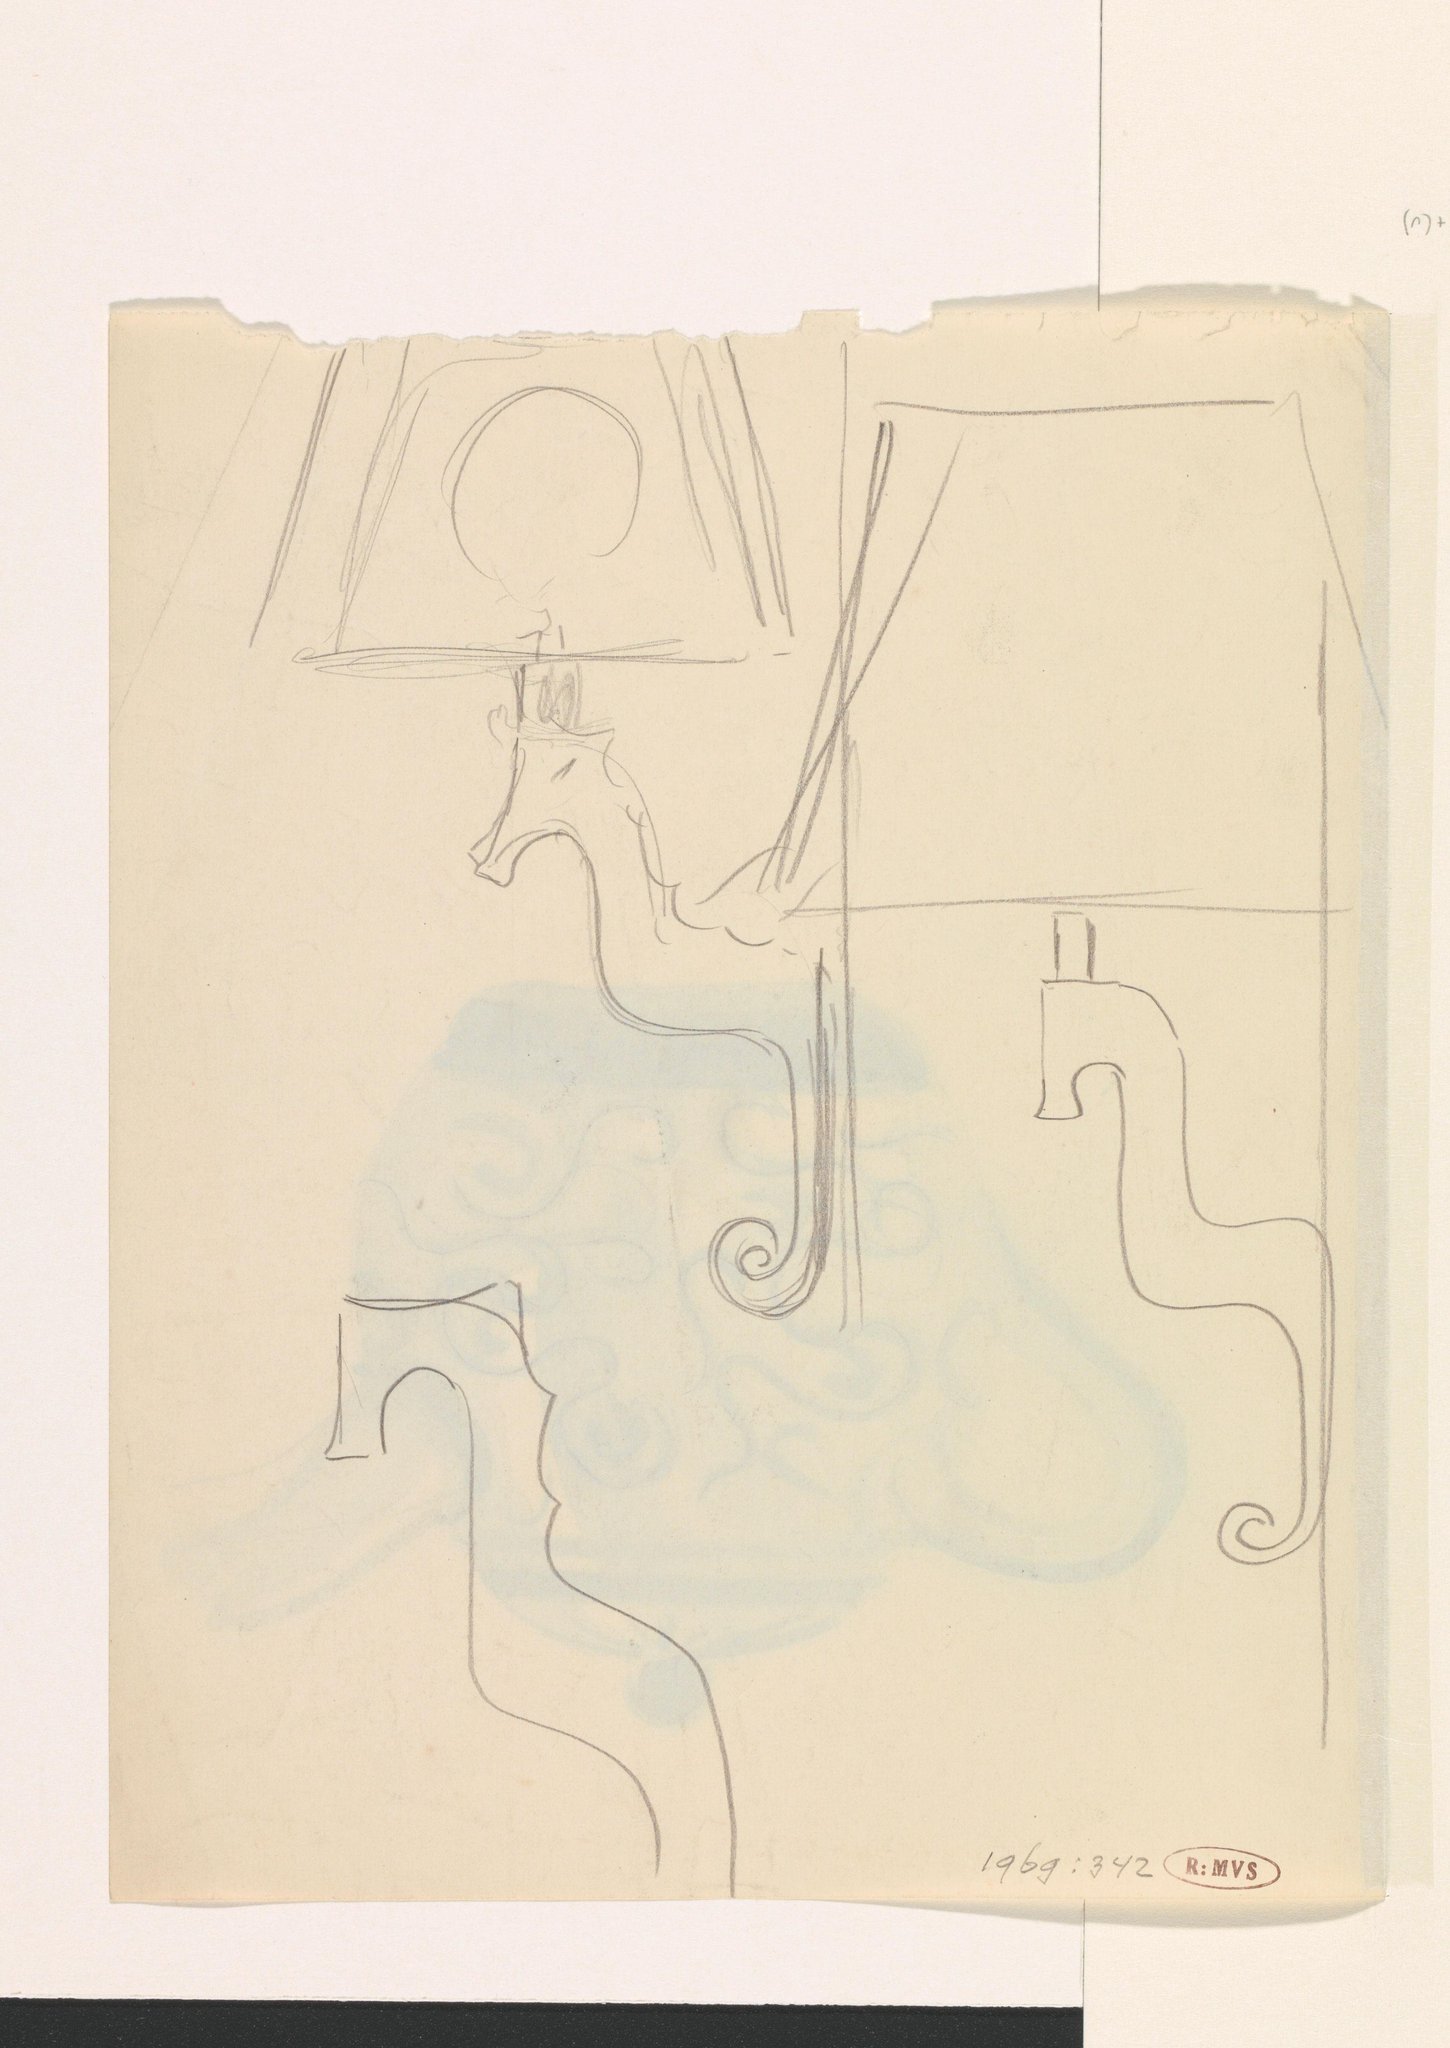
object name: drawing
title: Ontwerp voor een muurlamp, in de vorm van een zeepaardje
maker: carel adolph lion cachet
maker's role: draughtsman, print maker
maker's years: 1864-1945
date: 1874-1945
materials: paper, pencil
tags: ornament derived from animal forms, bony fishes: seahorse, electric lamp